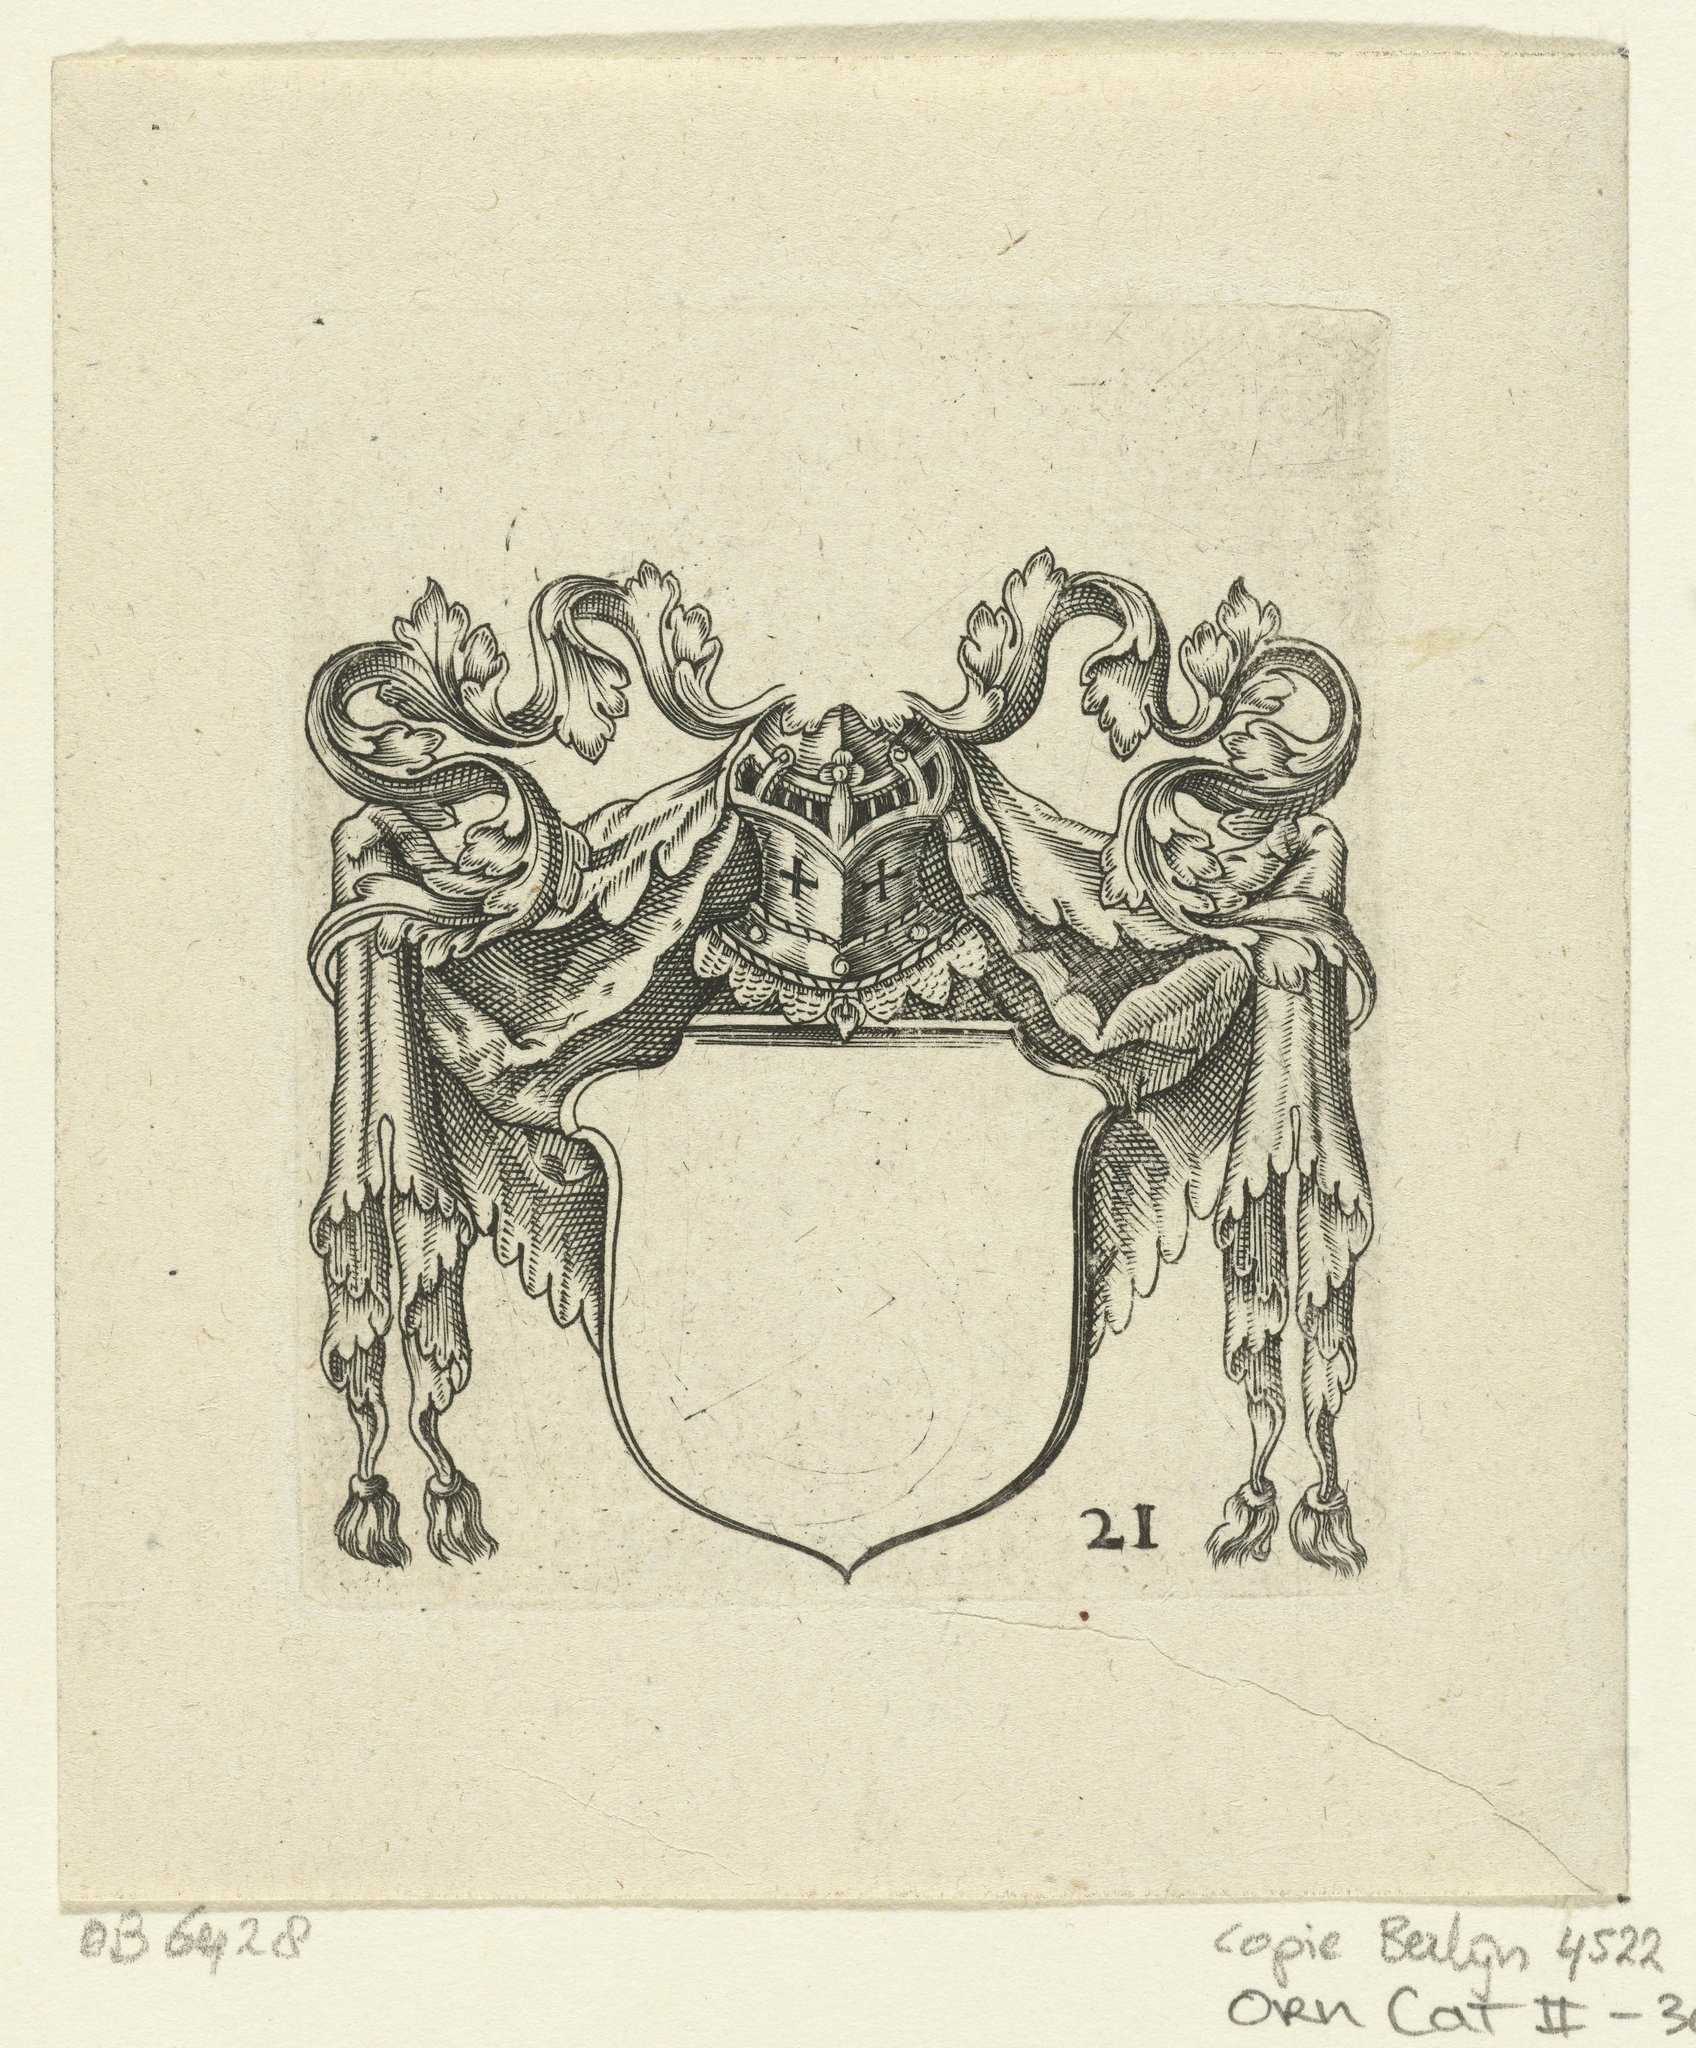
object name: ornament print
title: Verscheyden Wapenen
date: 1625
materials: paper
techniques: engraving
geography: amsterdam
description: Zowel links als rechts hangen een draperie en een bladrank. Tegenzijdige kopie naar wapenschild van Theodor de Bry in het boek Emblemata Nobilitati.... Blad uit serie wapenschilden met lege compartimenten.